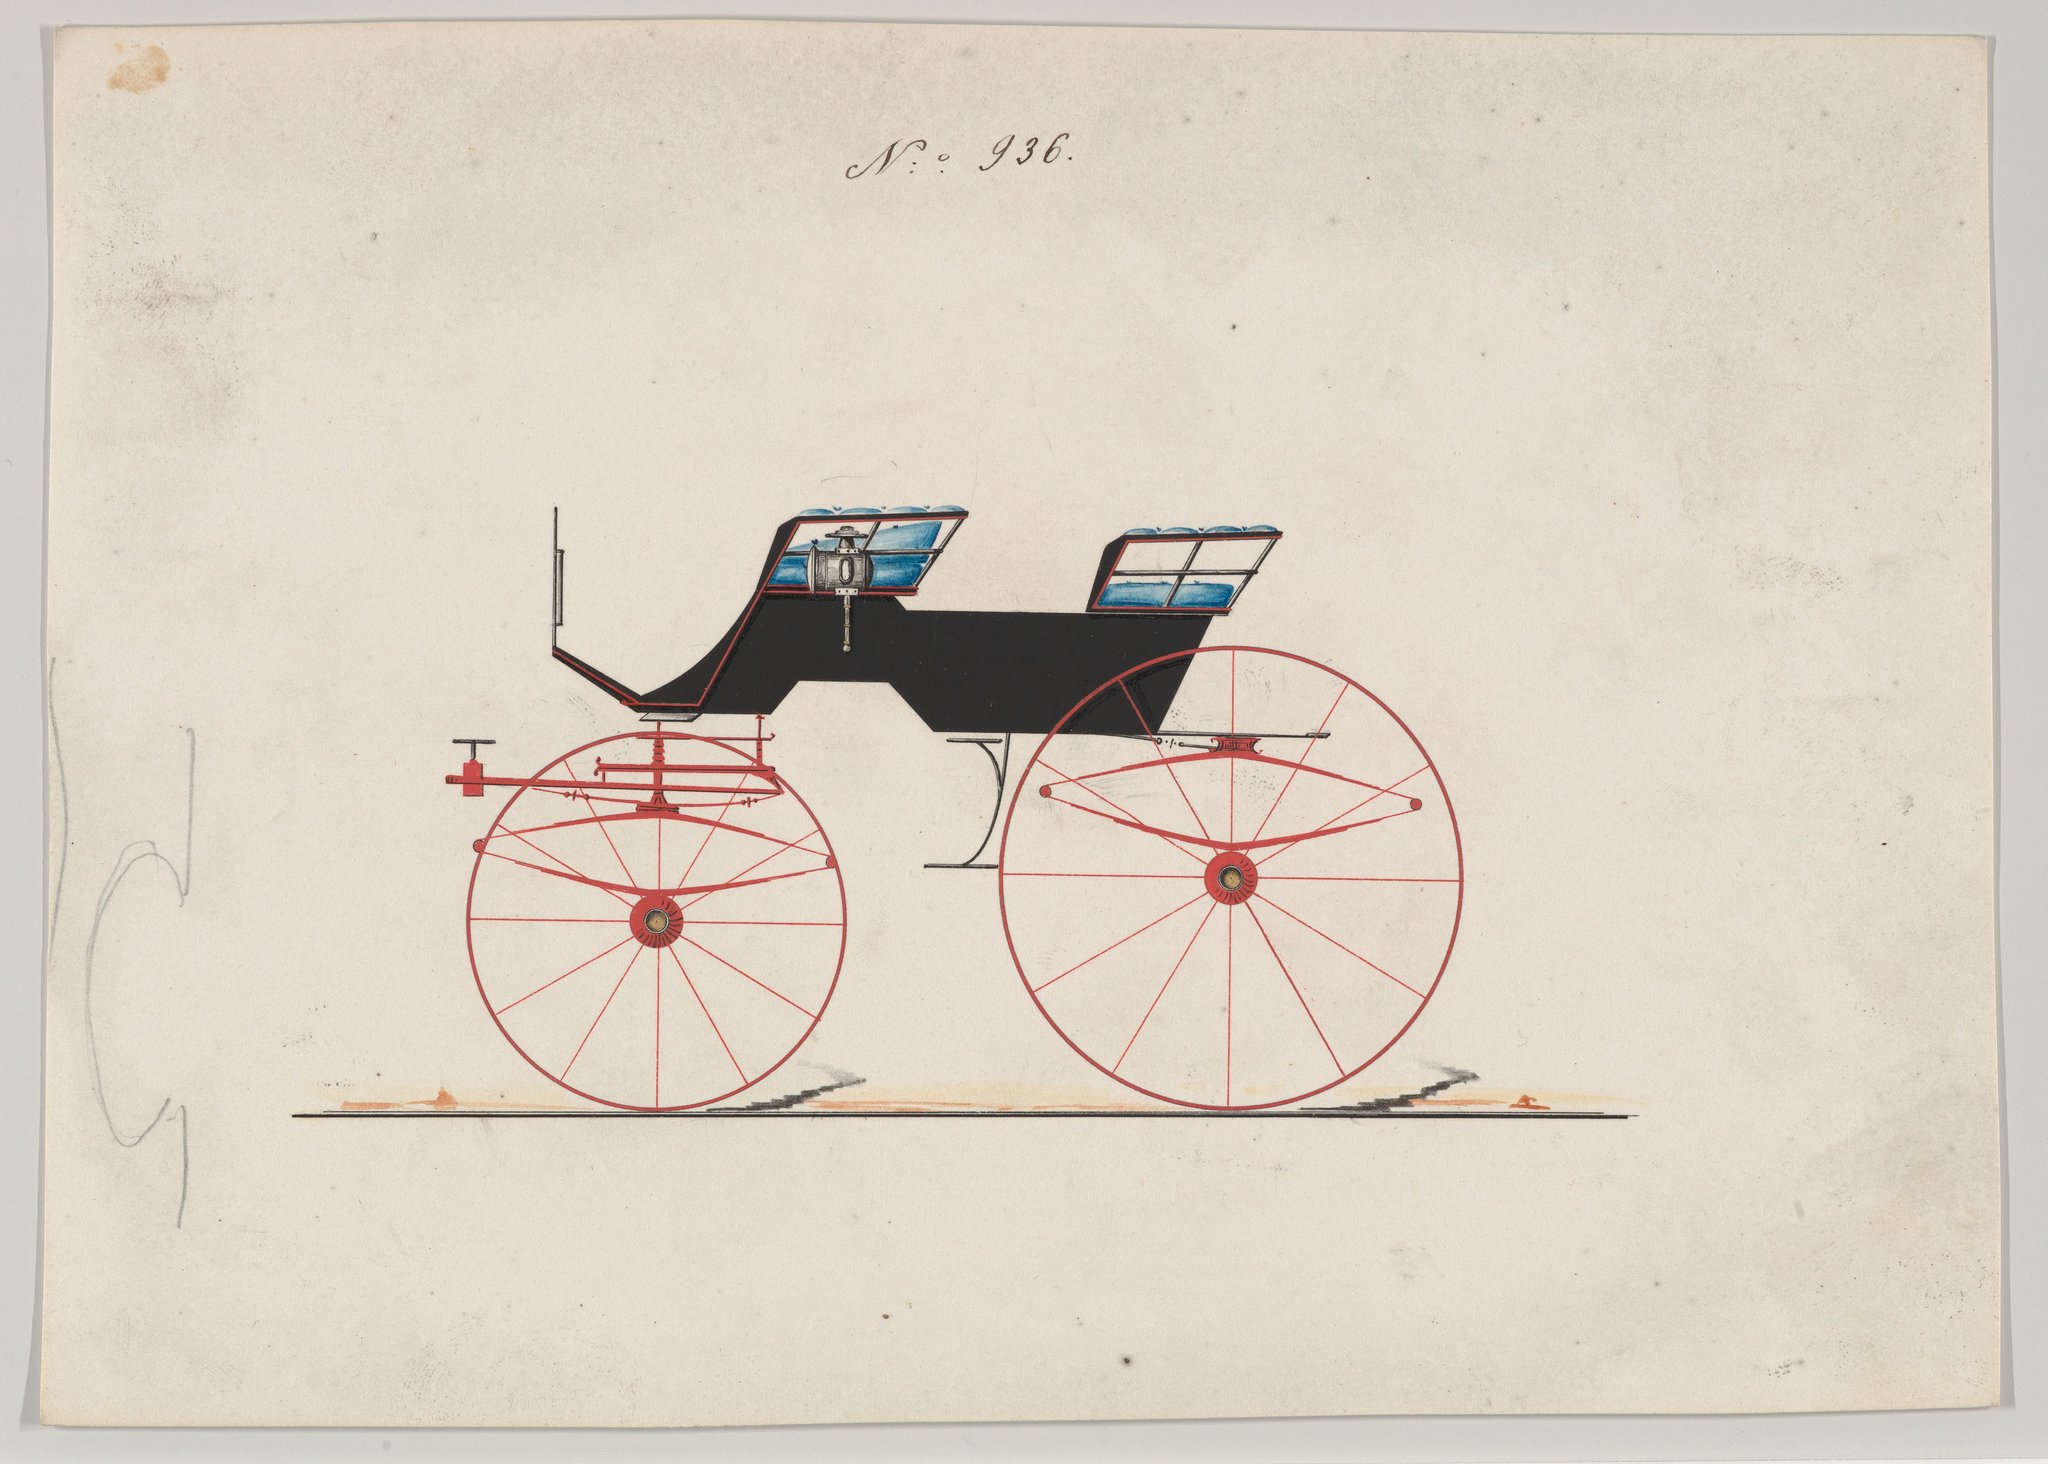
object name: drawing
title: Phaeton # 936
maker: brewster & co.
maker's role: manufacturer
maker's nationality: american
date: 1850-1870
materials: graphite, gum arabic, ink, watercolor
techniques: pen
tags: carriages